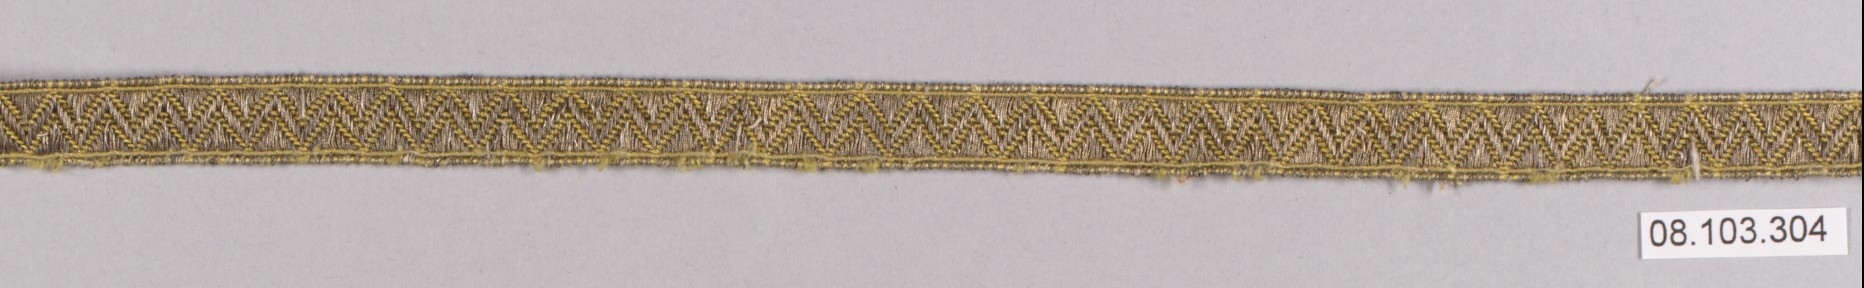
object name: galloon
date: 1601-1800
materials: metal thread, silk